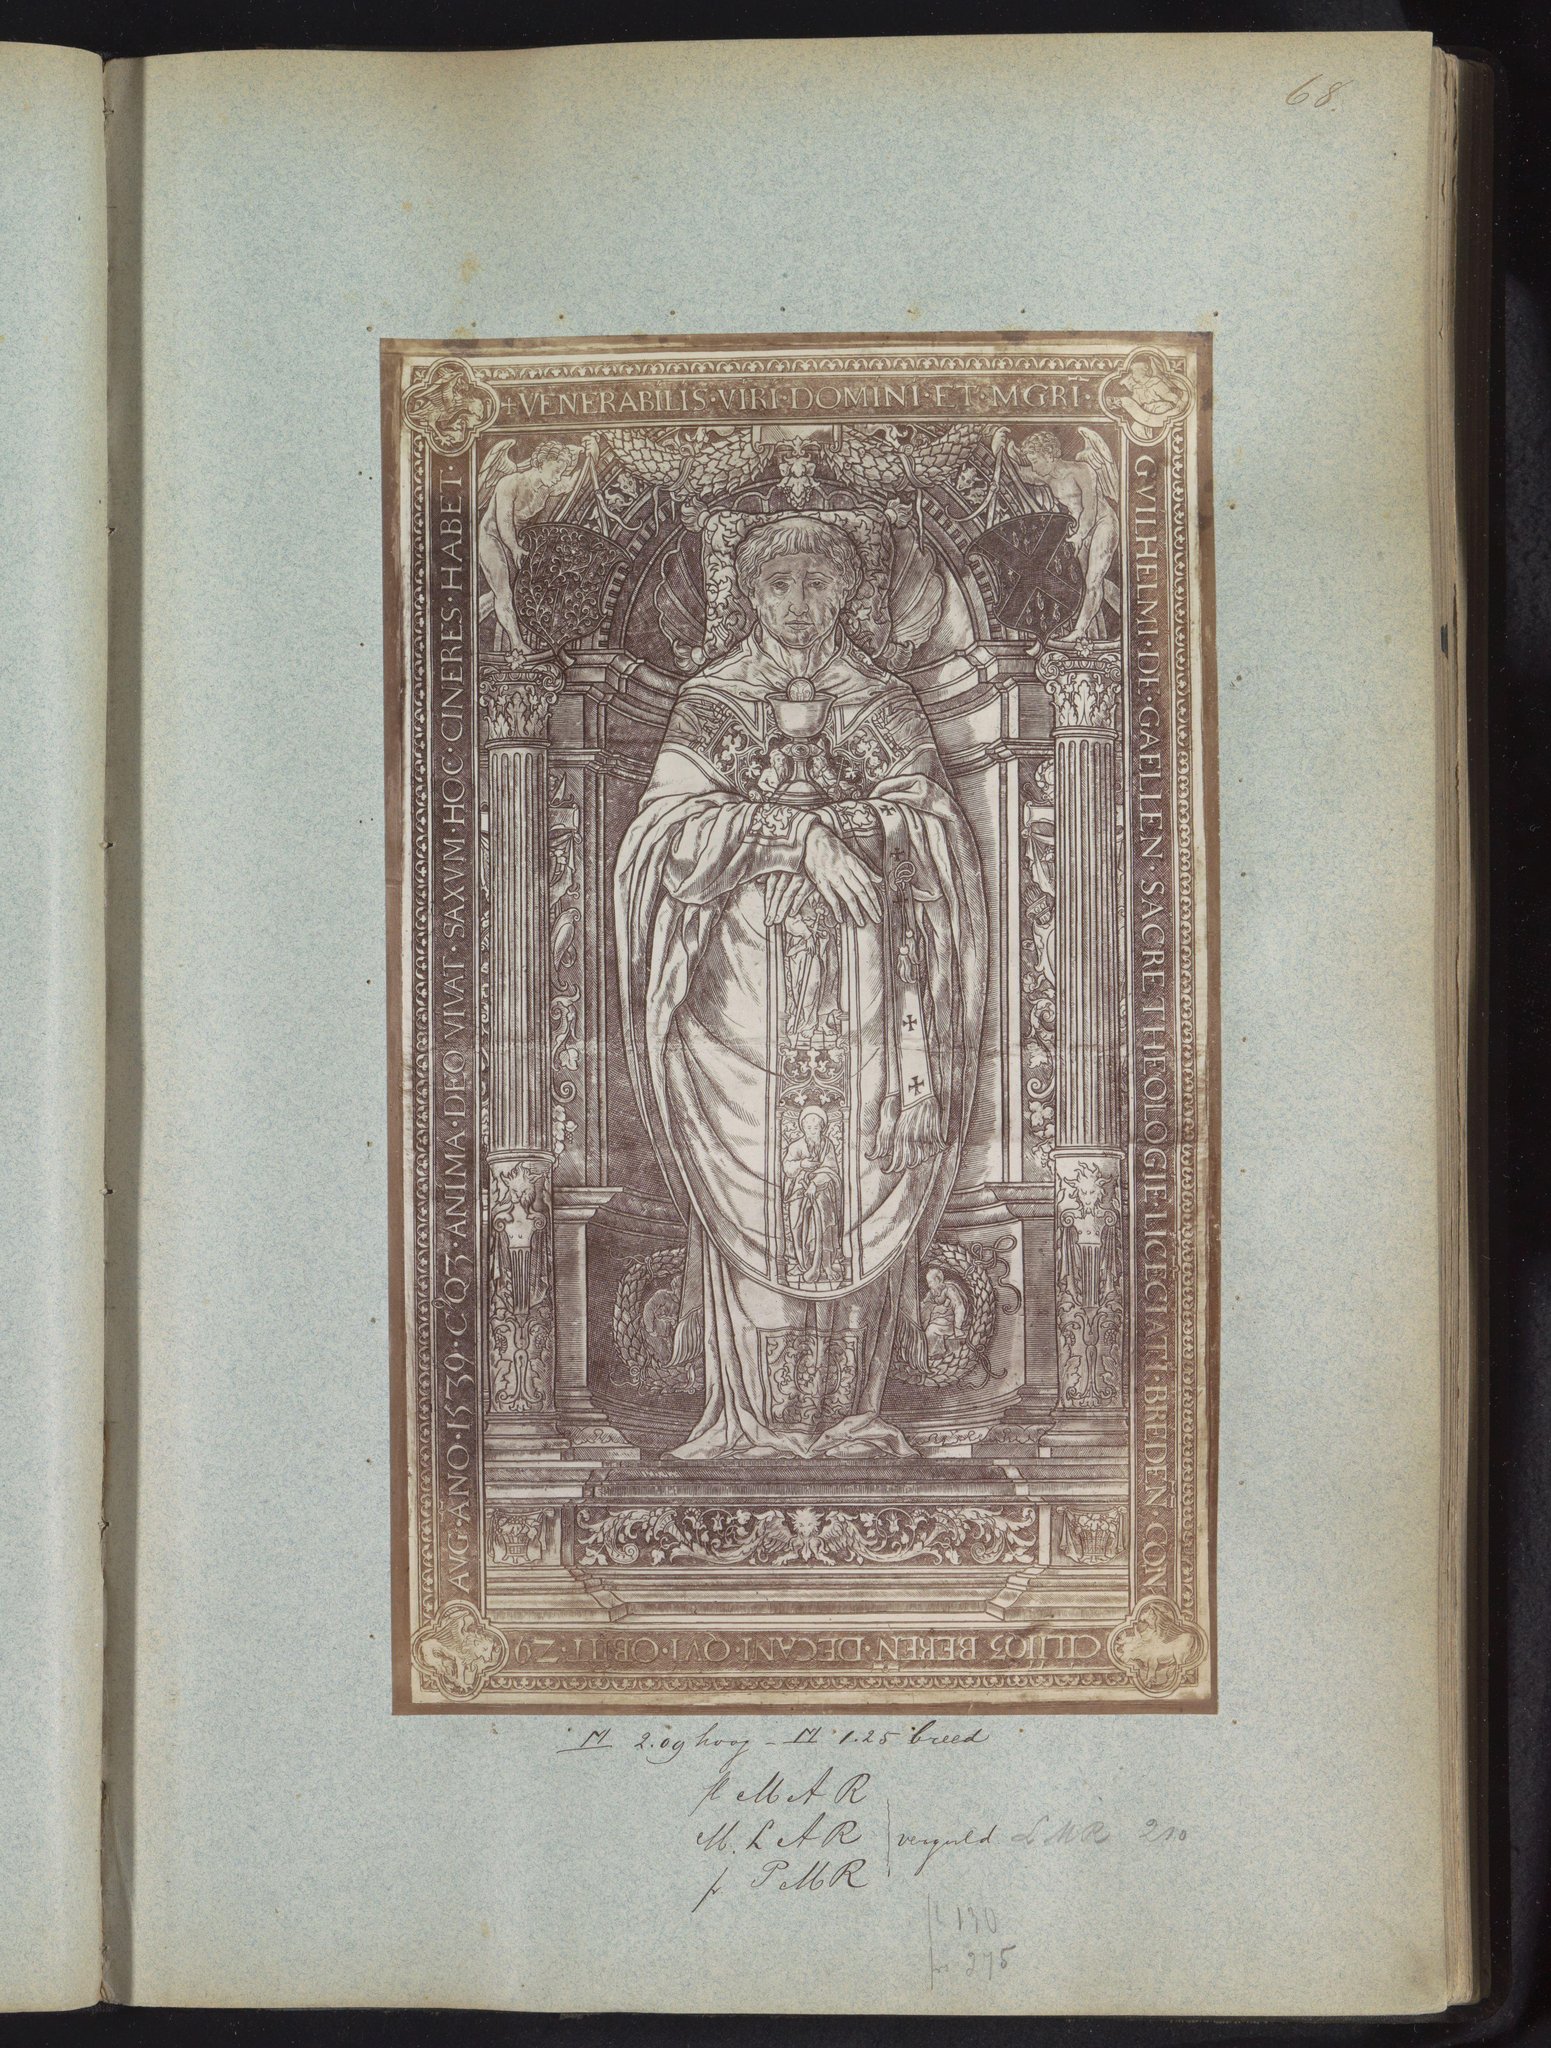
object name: album leaf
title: Heilige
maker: Anonymous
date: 1875-1900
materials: paper, photographic support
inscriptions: annotation, annotation: ‘M 2.09 hoog - M 1.25 breed’